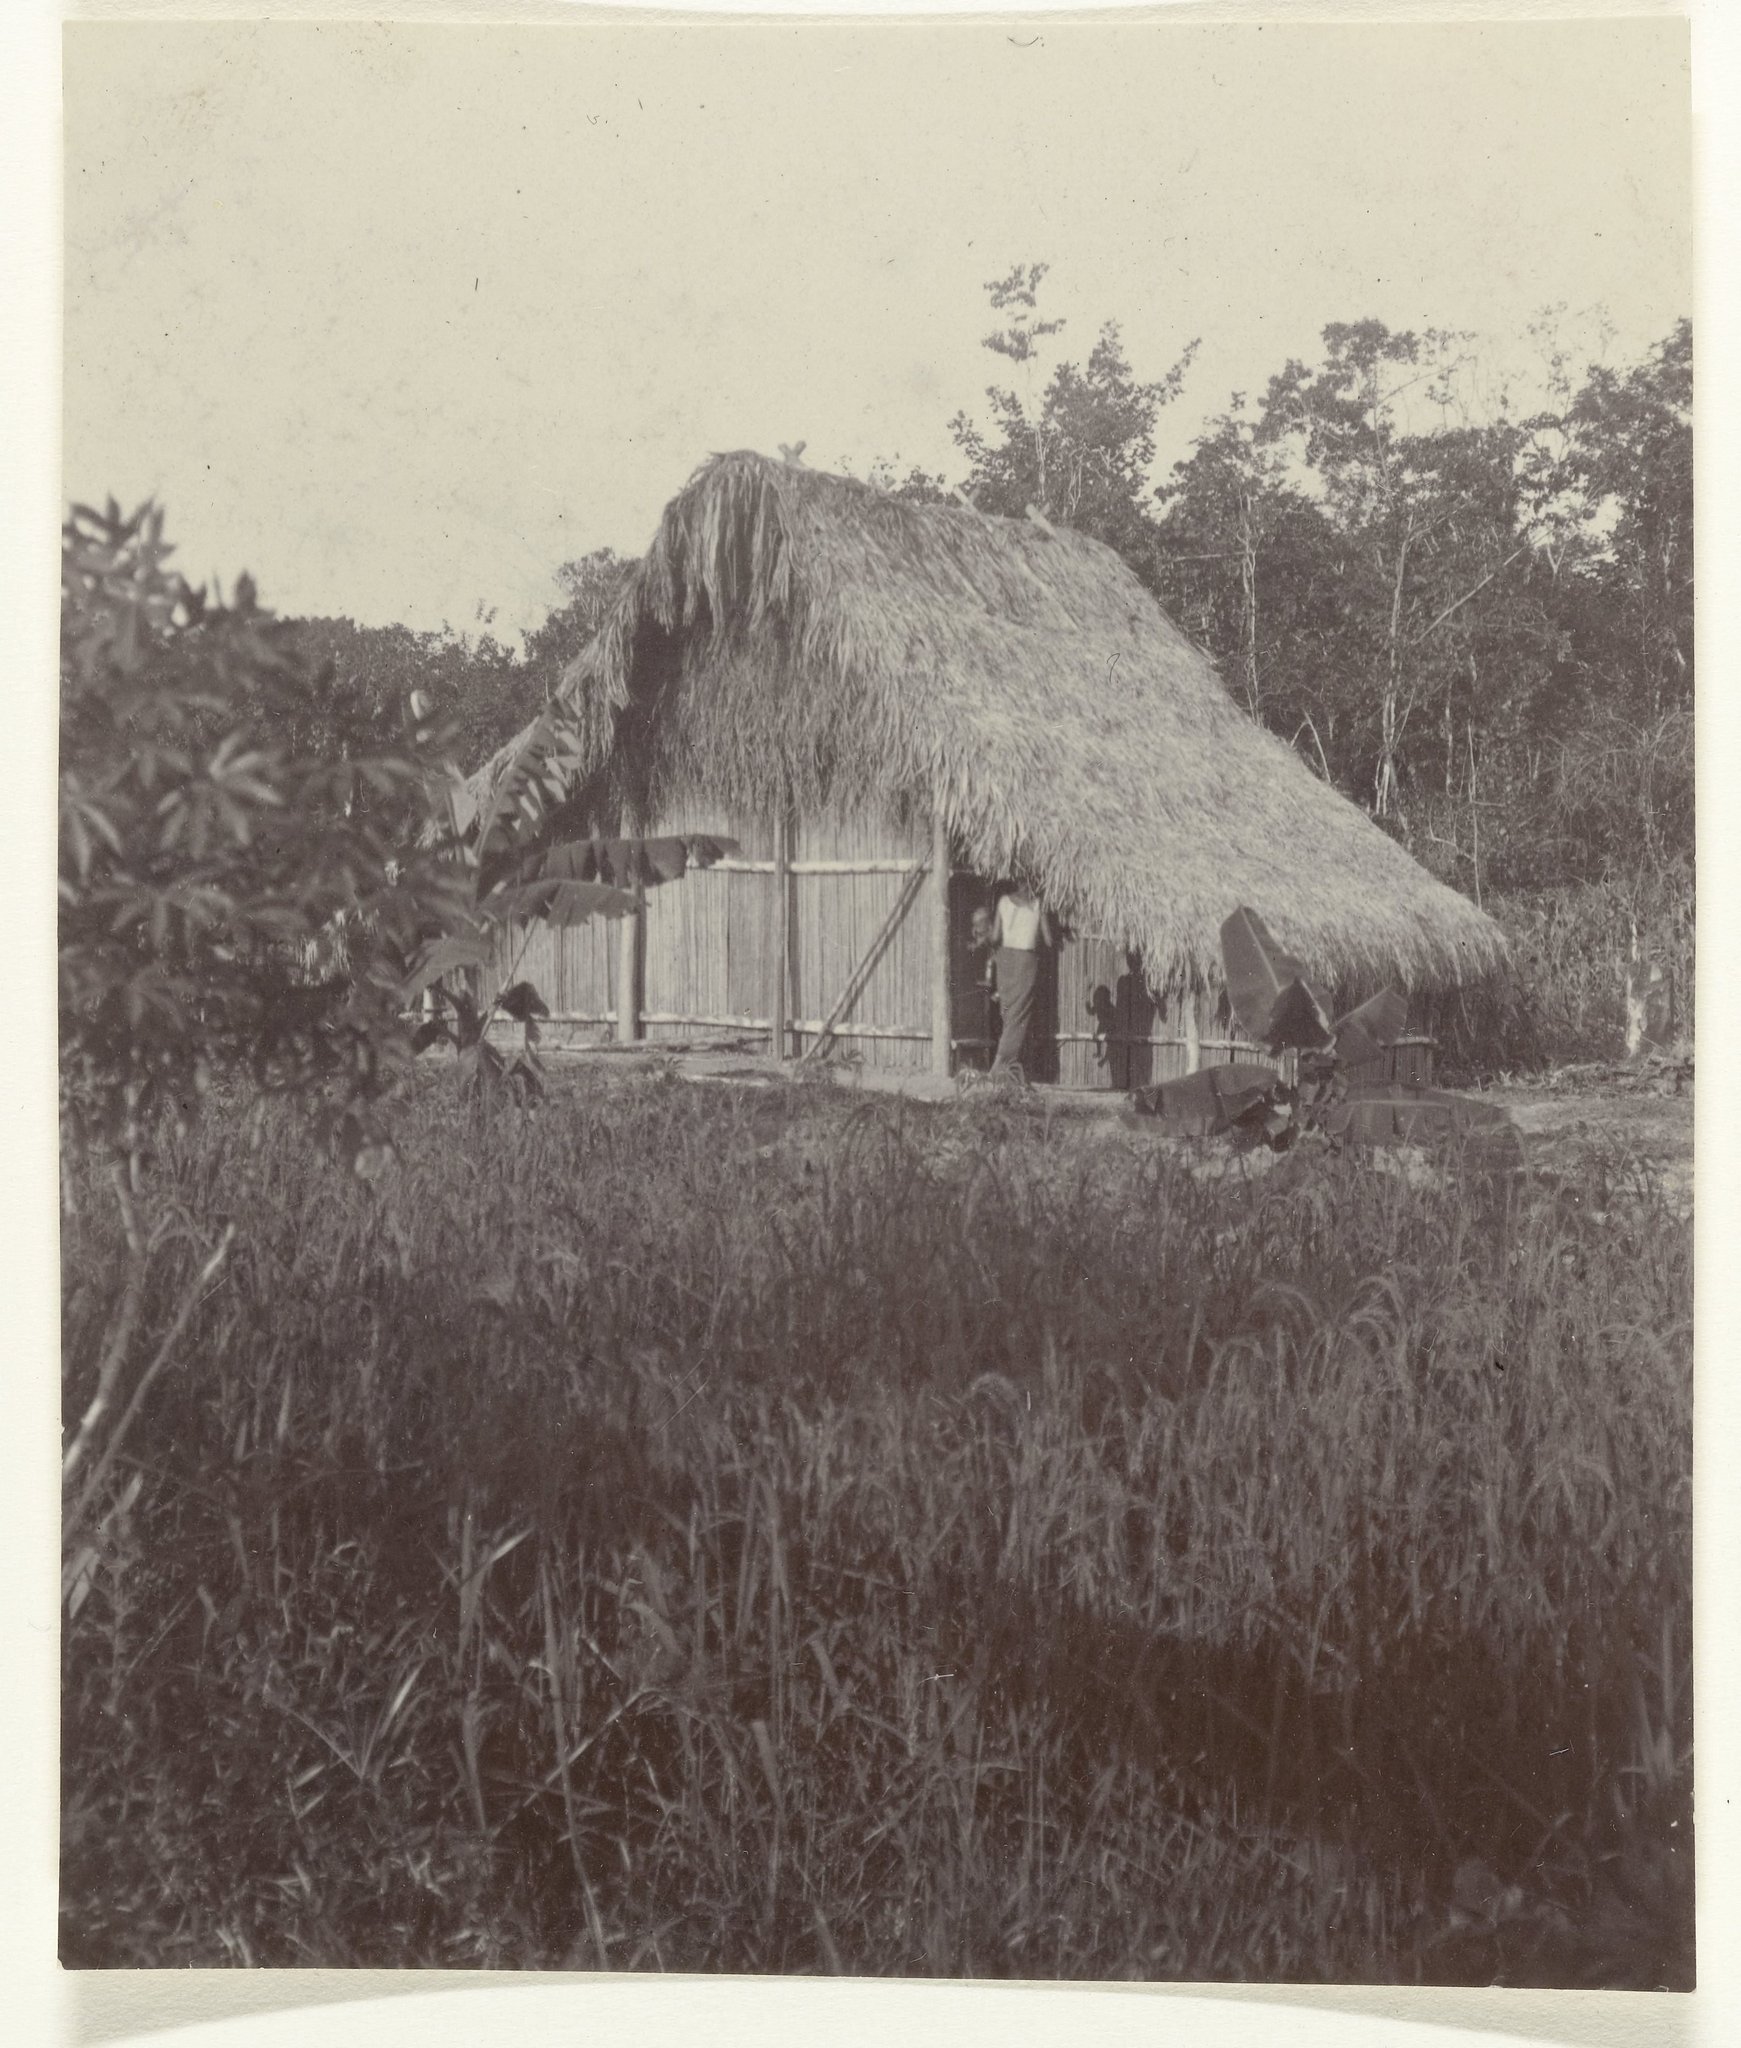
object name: photograph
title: Hindustani and Javanese Indentured Labourers at the Accaribo Plantation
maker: theodoor brouwers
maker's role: amateurfotograaf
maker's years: 1874-1932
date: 1916-1930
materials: photographic support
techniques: photography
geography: suriname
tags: theodoor brouwers, plantation, suriname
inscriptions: inscription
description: Both Javanese and Hindustani contract labourers work on the Accaribo Plantation. Their homes are located on the edge of the plantation. They often develop close ties and exchange cultural traditions. While their parents work, the two young Hindustani girls look after the little ones, assuming great responsibility at an early age.